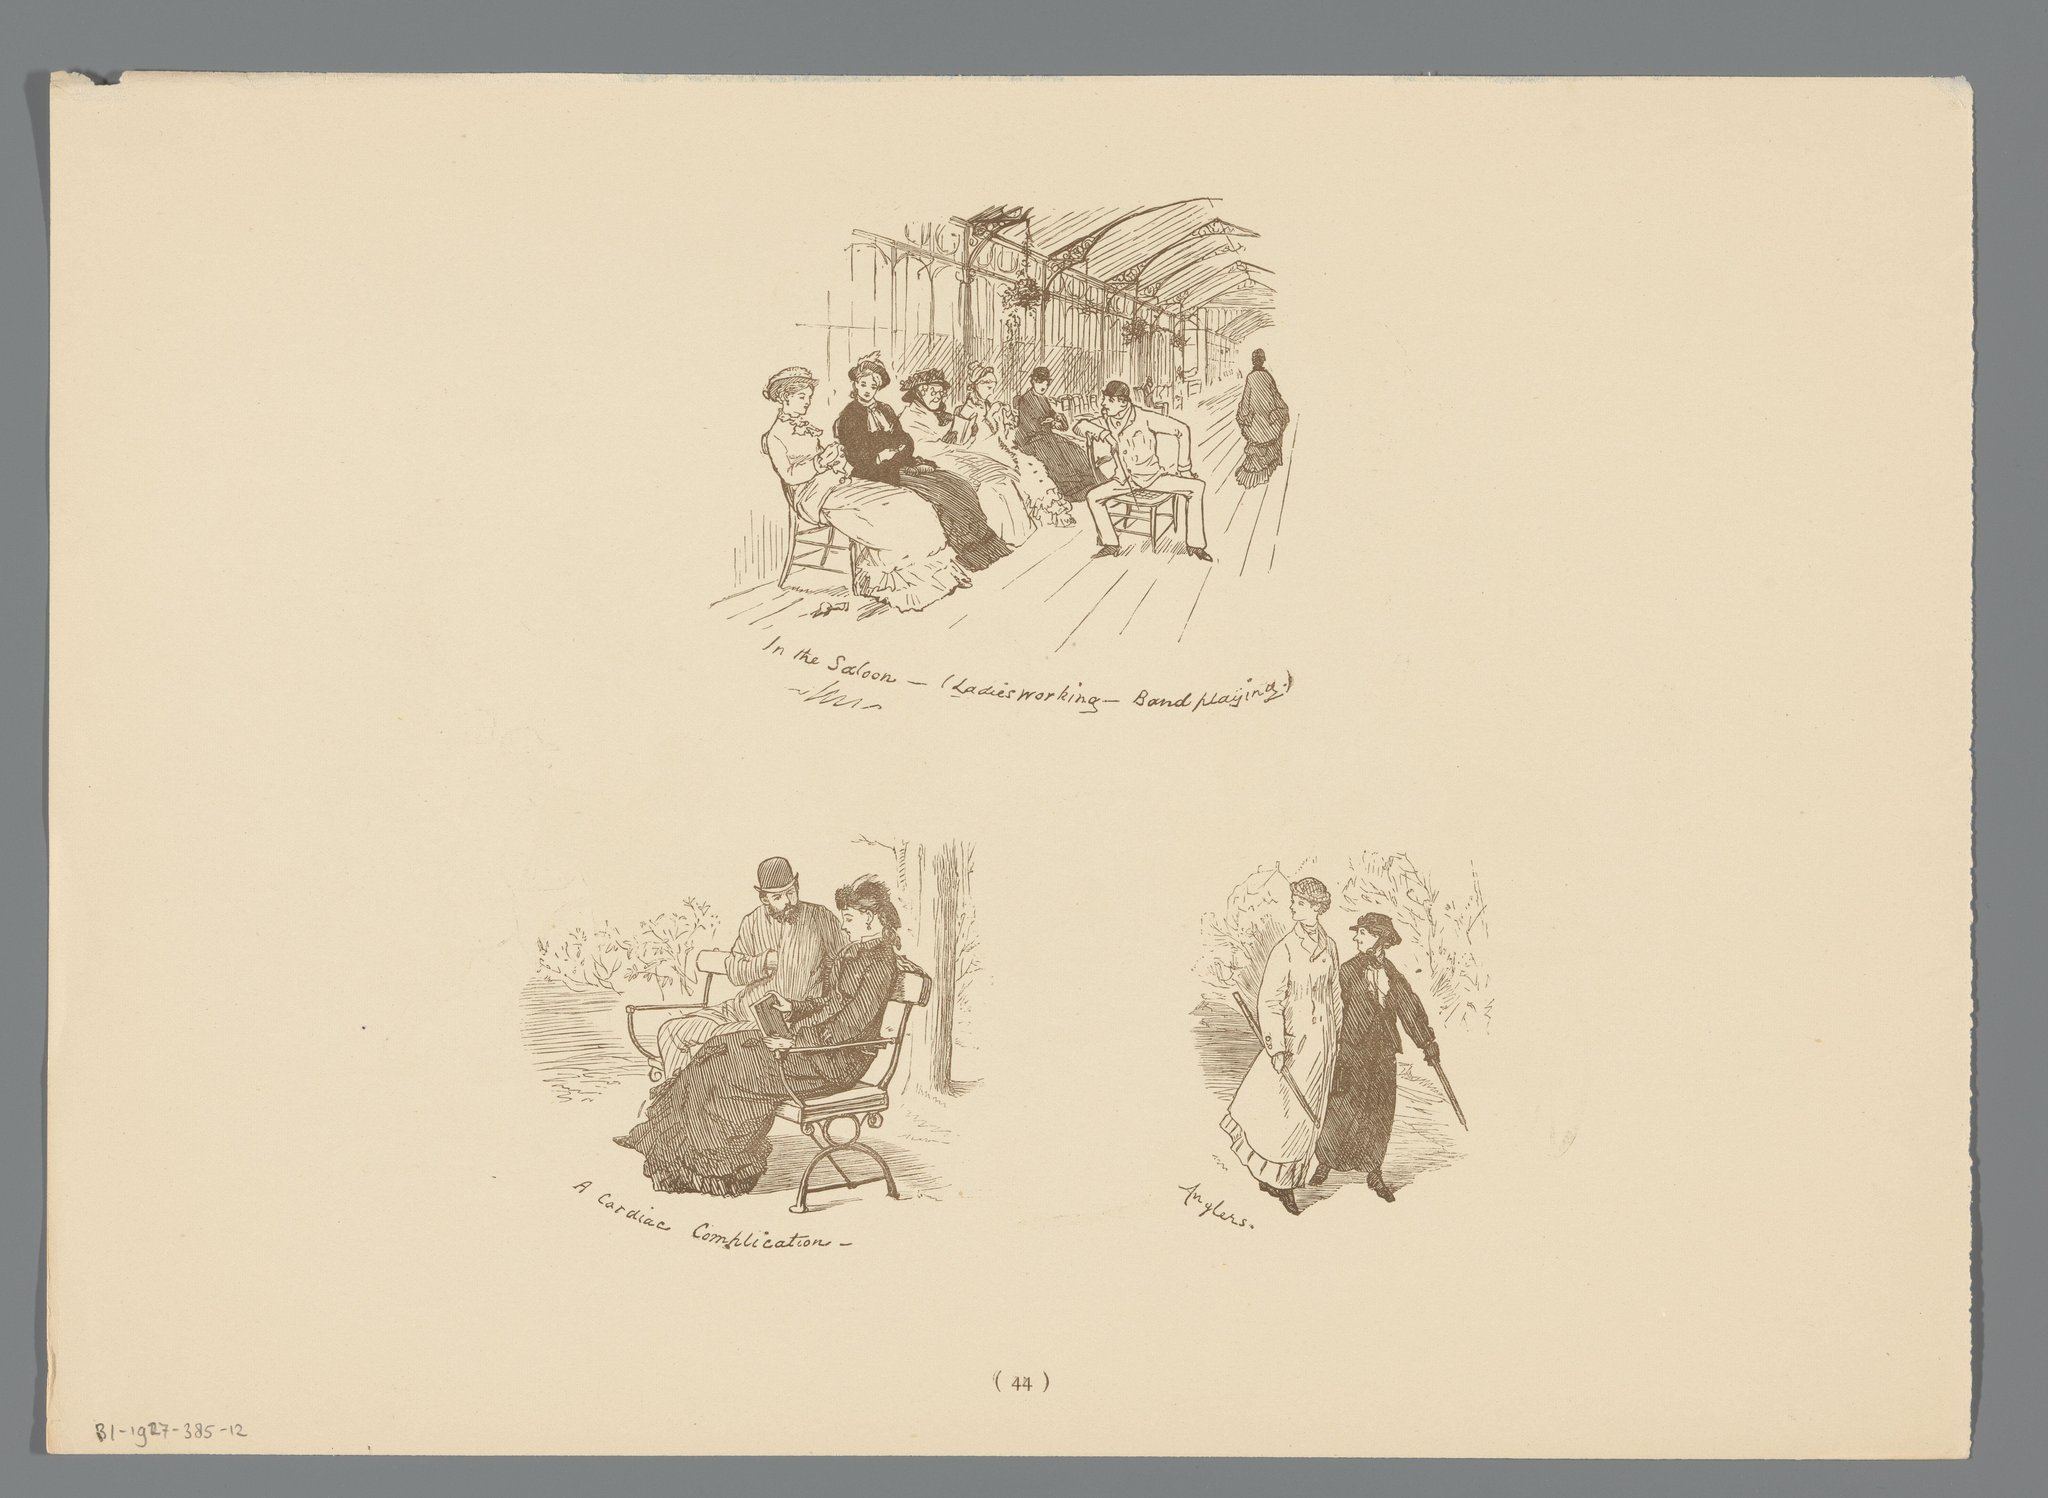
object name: print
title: A cardiac complication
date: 1889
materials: paper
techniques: letterpress printing, engraving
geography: london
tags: adult woman, recreation, amusement, adult man, inn, coffee-house, public house, etc.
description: Prent uit: Gleanings from the Graphic. Londen: George Routledge & Sons, 1889. Dit werk is een bundel van diverse illustraties die eerder verschenen in verschillende jaargangen van het Engelse weekblad 'The Graphic'. De bundel is na het overlijden van Randolph Caldecott uitgegeven.